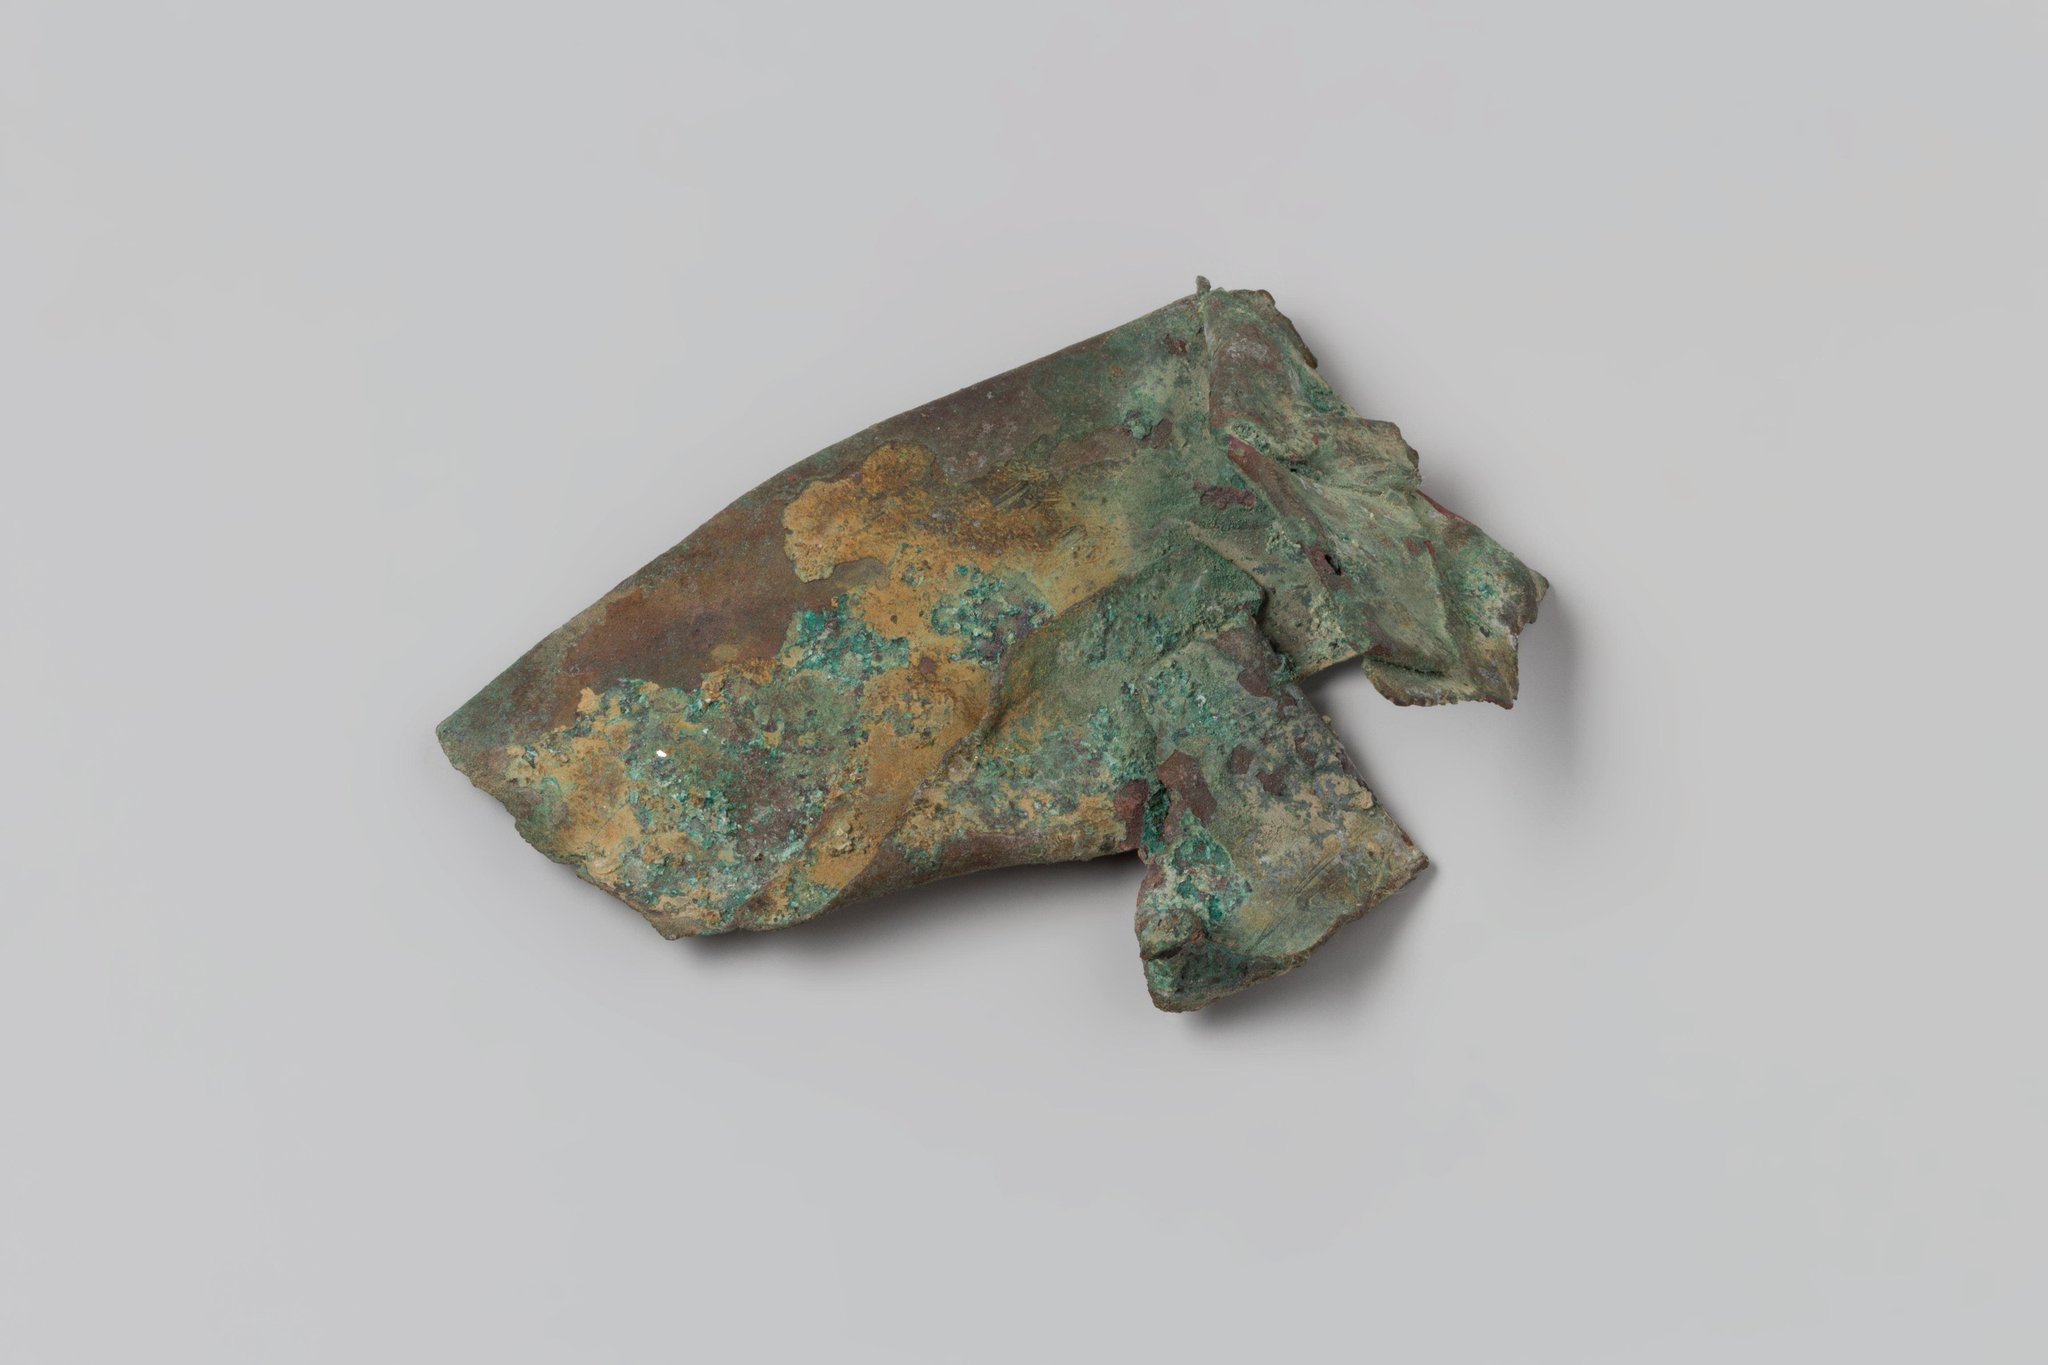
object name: scheepswrakvondst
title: Fragment van koper uit het wrak van de Oost-Indiëvaarder Hollandia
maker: Anonymous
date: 1700-1743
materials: copper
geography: netherlands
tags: verenigde oostindische compagnie, hollandia (schip), annet